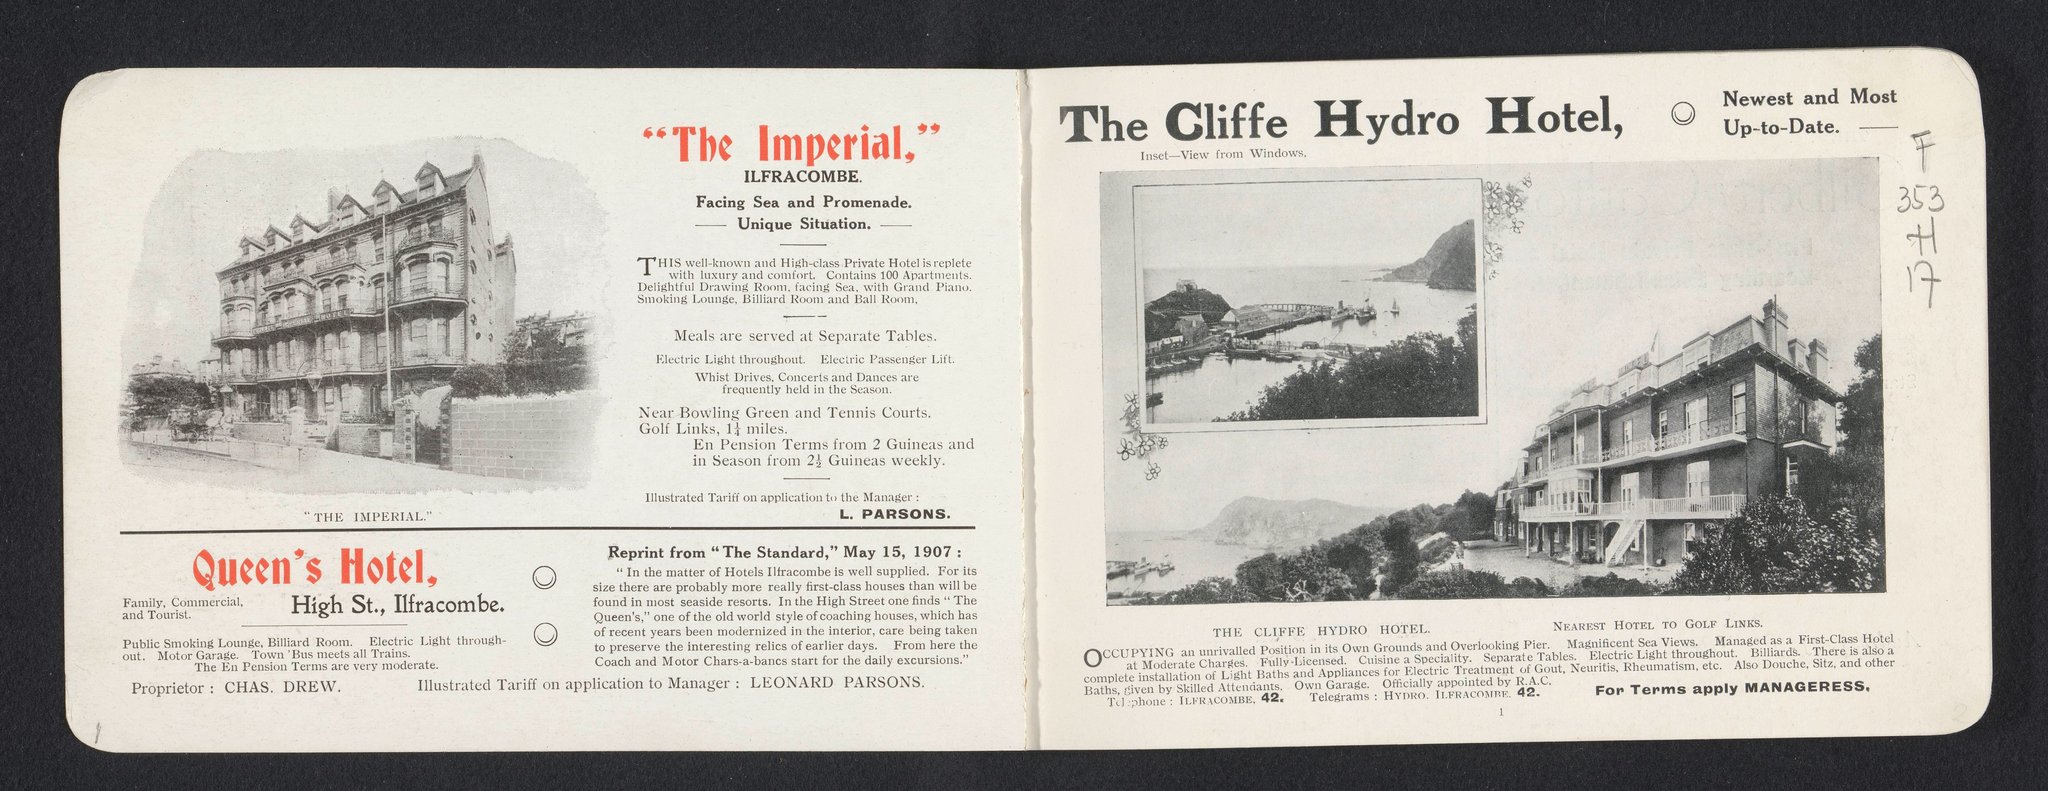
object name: page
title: Voorgevel van het Cliffe Hydro Hotel te Ilfracombe en een uitzicht vanuit het hotel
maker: Anonymous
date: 1900-1920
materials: paper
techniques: autotype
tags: view through a window from the inside, façade (of house or building), hotel, hostelry, inn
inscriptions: inscription: ‘The Cliffe Hydro Hotel (...) For Terms apply manageress.’